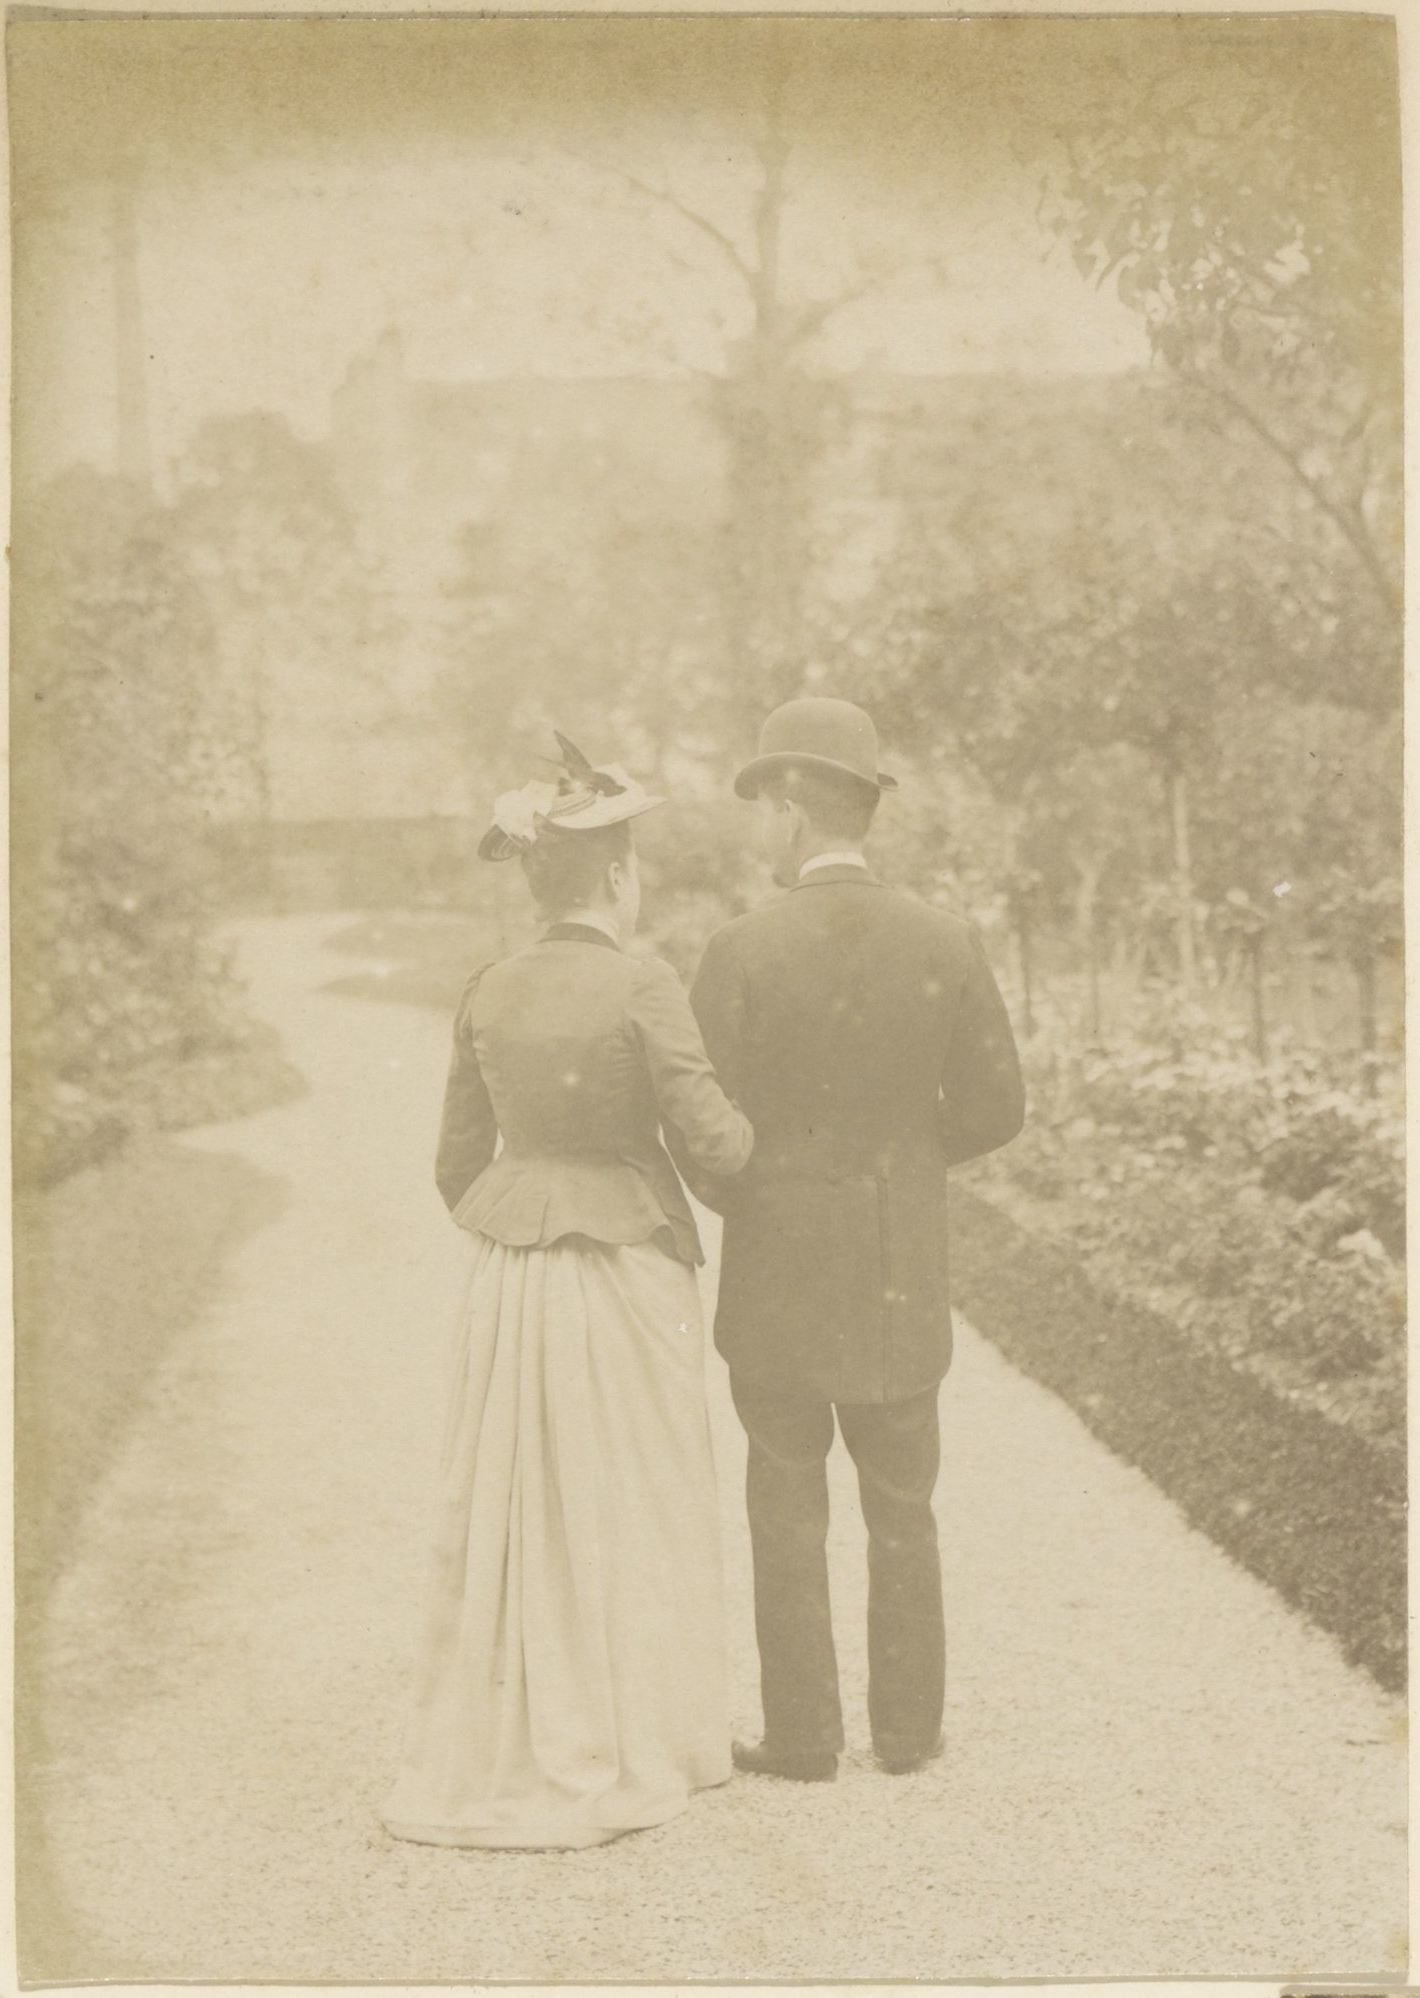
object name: photograph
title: Portret van een Frans stel, op de rug gezien in een tuin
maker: Anonymous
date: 1900-1910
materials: paper, photographic support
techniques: albumen print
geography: france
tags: garden, marriage, married couple, 'matrimonium', france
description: Onderdeel van Fotoalbum van een Franse amateurfotograaf met opnames van een familie, distilleerderij Delizy & Doistau Fils, het leger en bezienswaardigheden in Frankrijk.